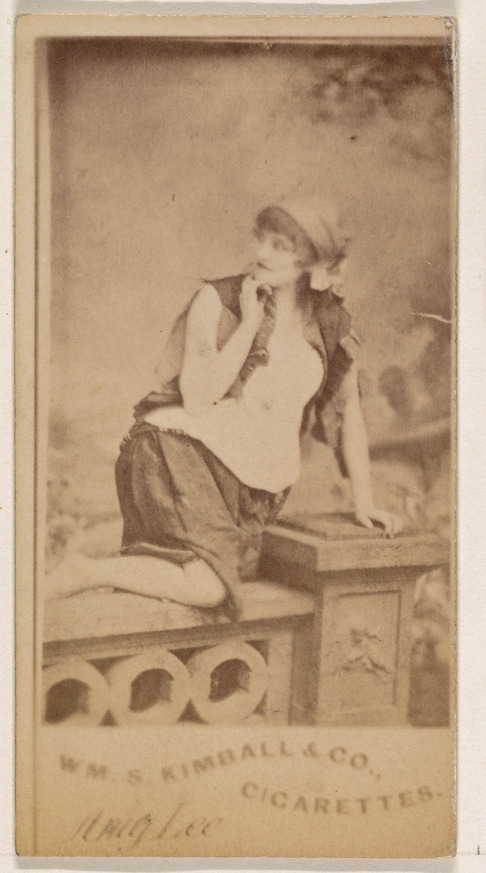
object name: photograph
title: Miss Lee, from the Actresses series (N203) issued by Wm. S. Kimball & Co.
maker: william s. kimball & company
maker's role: publisher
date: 1889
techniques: color lithograph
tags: portraits,women,actresses